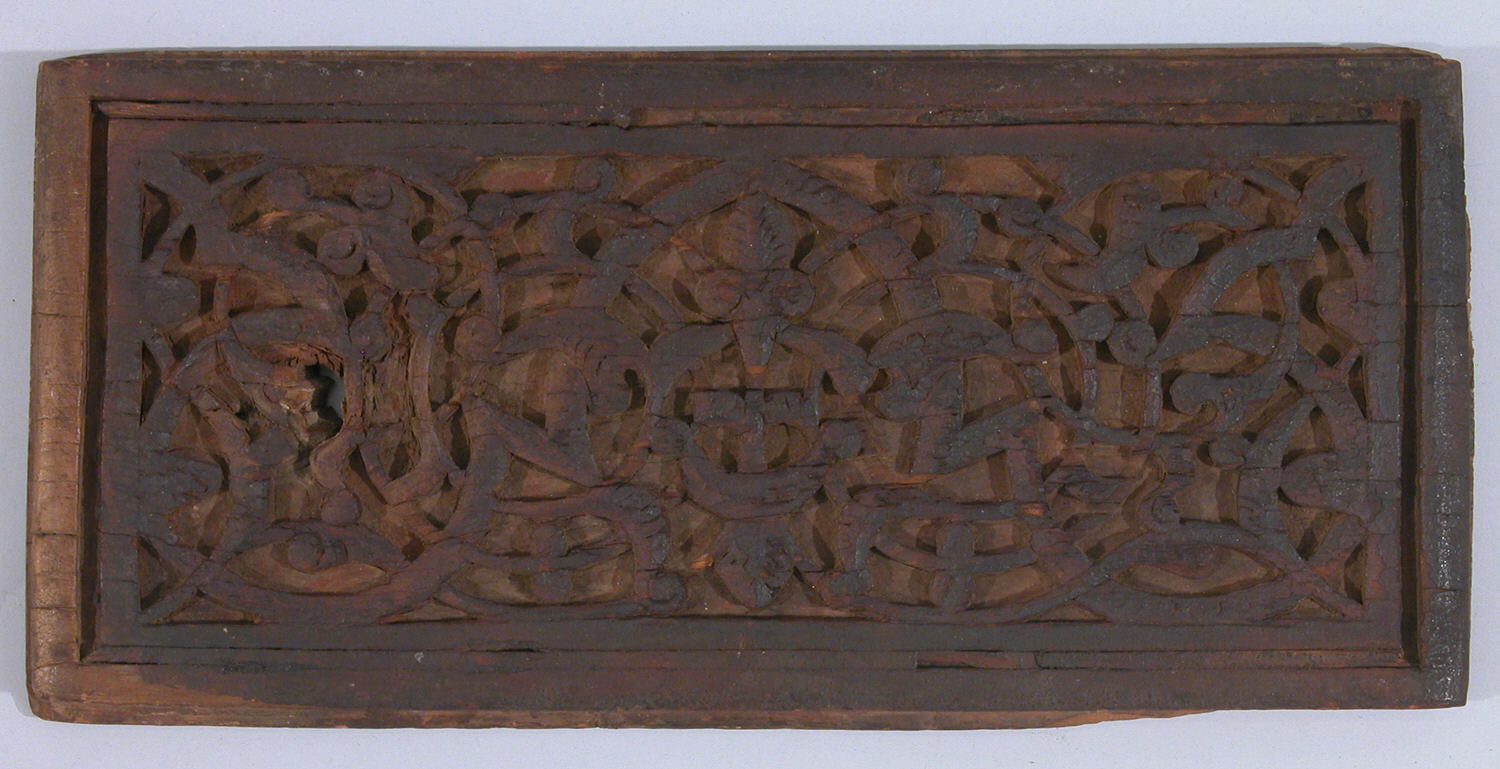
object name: panel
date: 909-1171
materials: wood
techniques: carving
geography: egypt